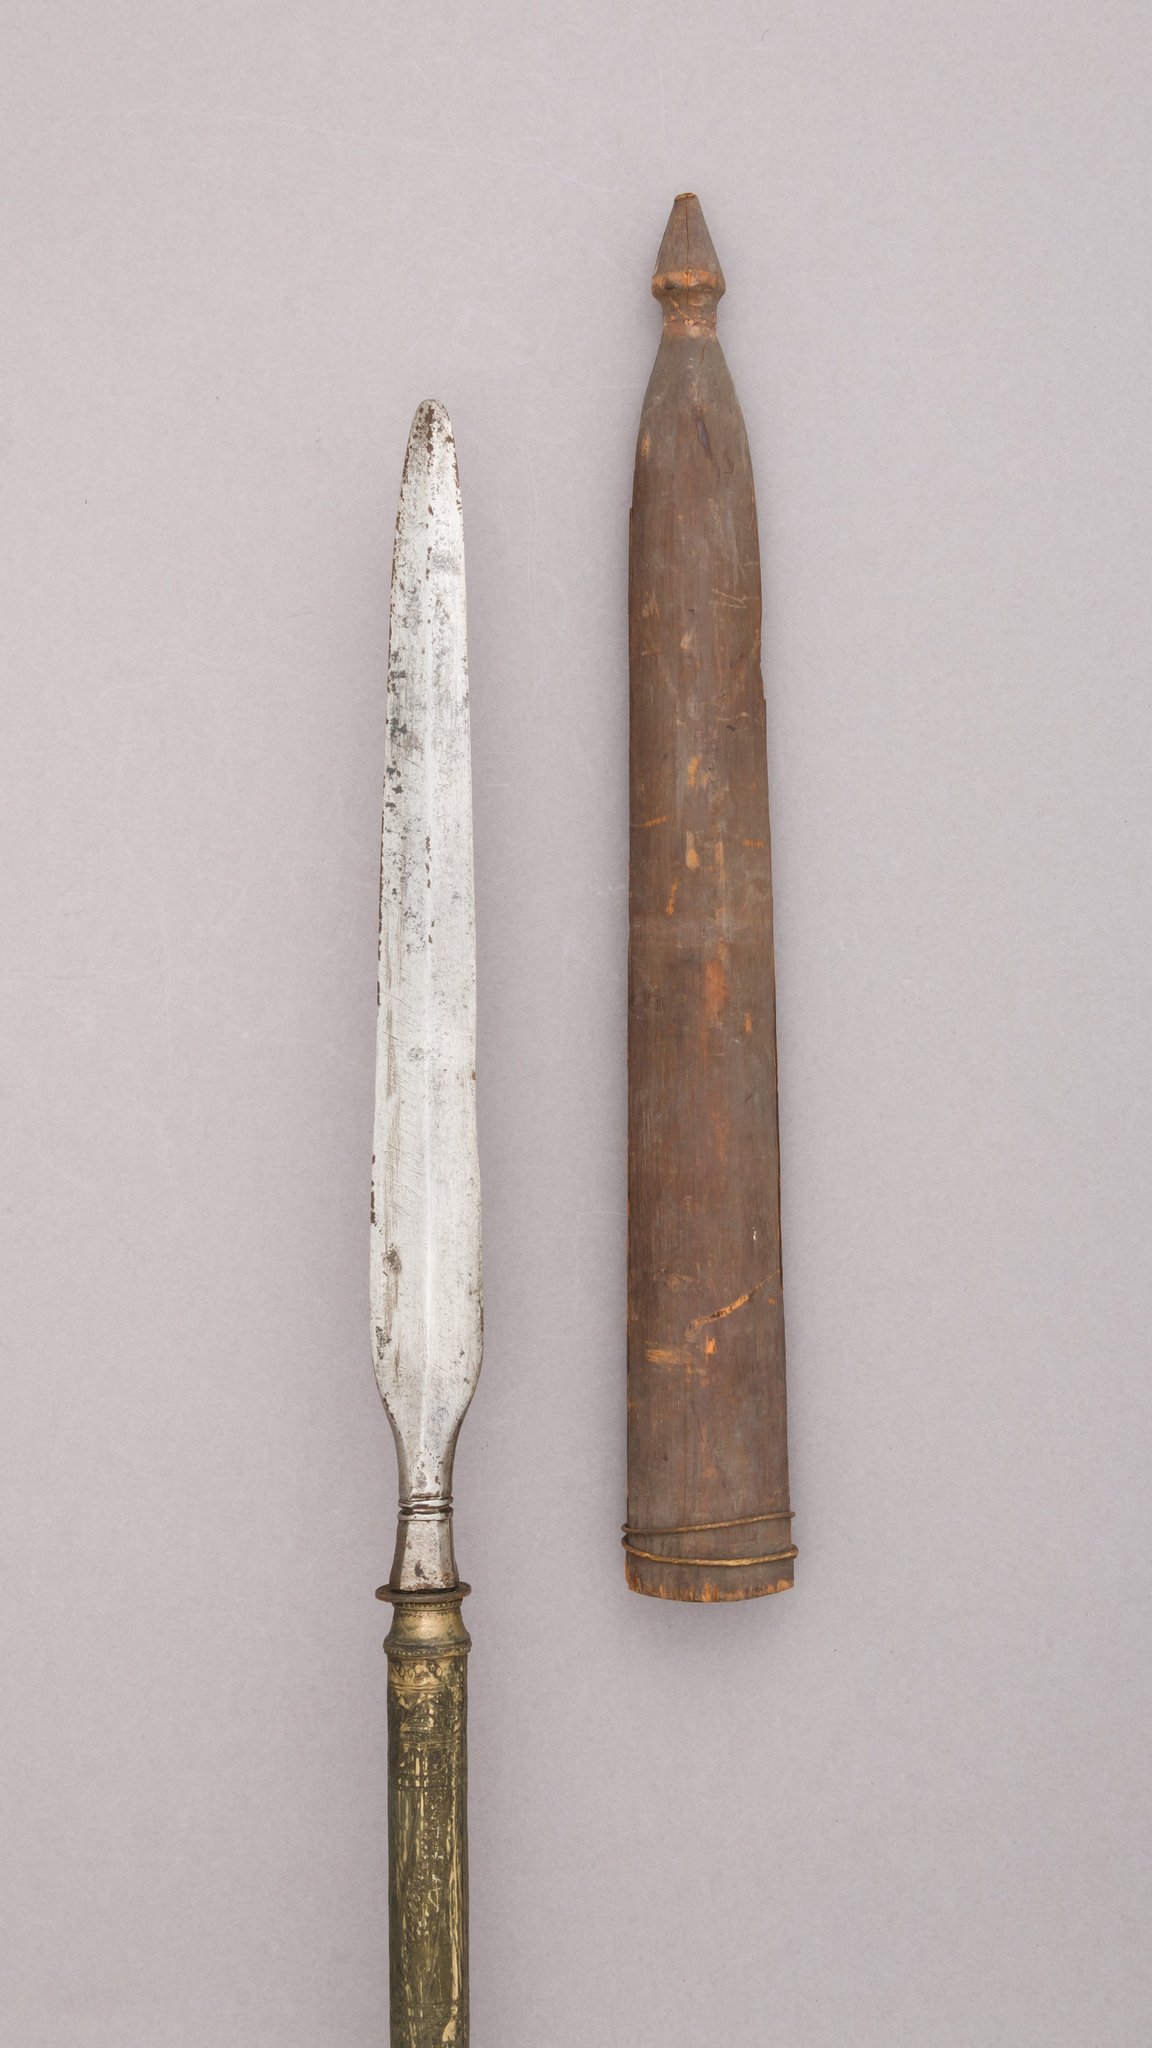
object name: spear with sheath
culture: sumatran or acheen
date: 1501-1900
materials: silver, wood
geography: indonesia